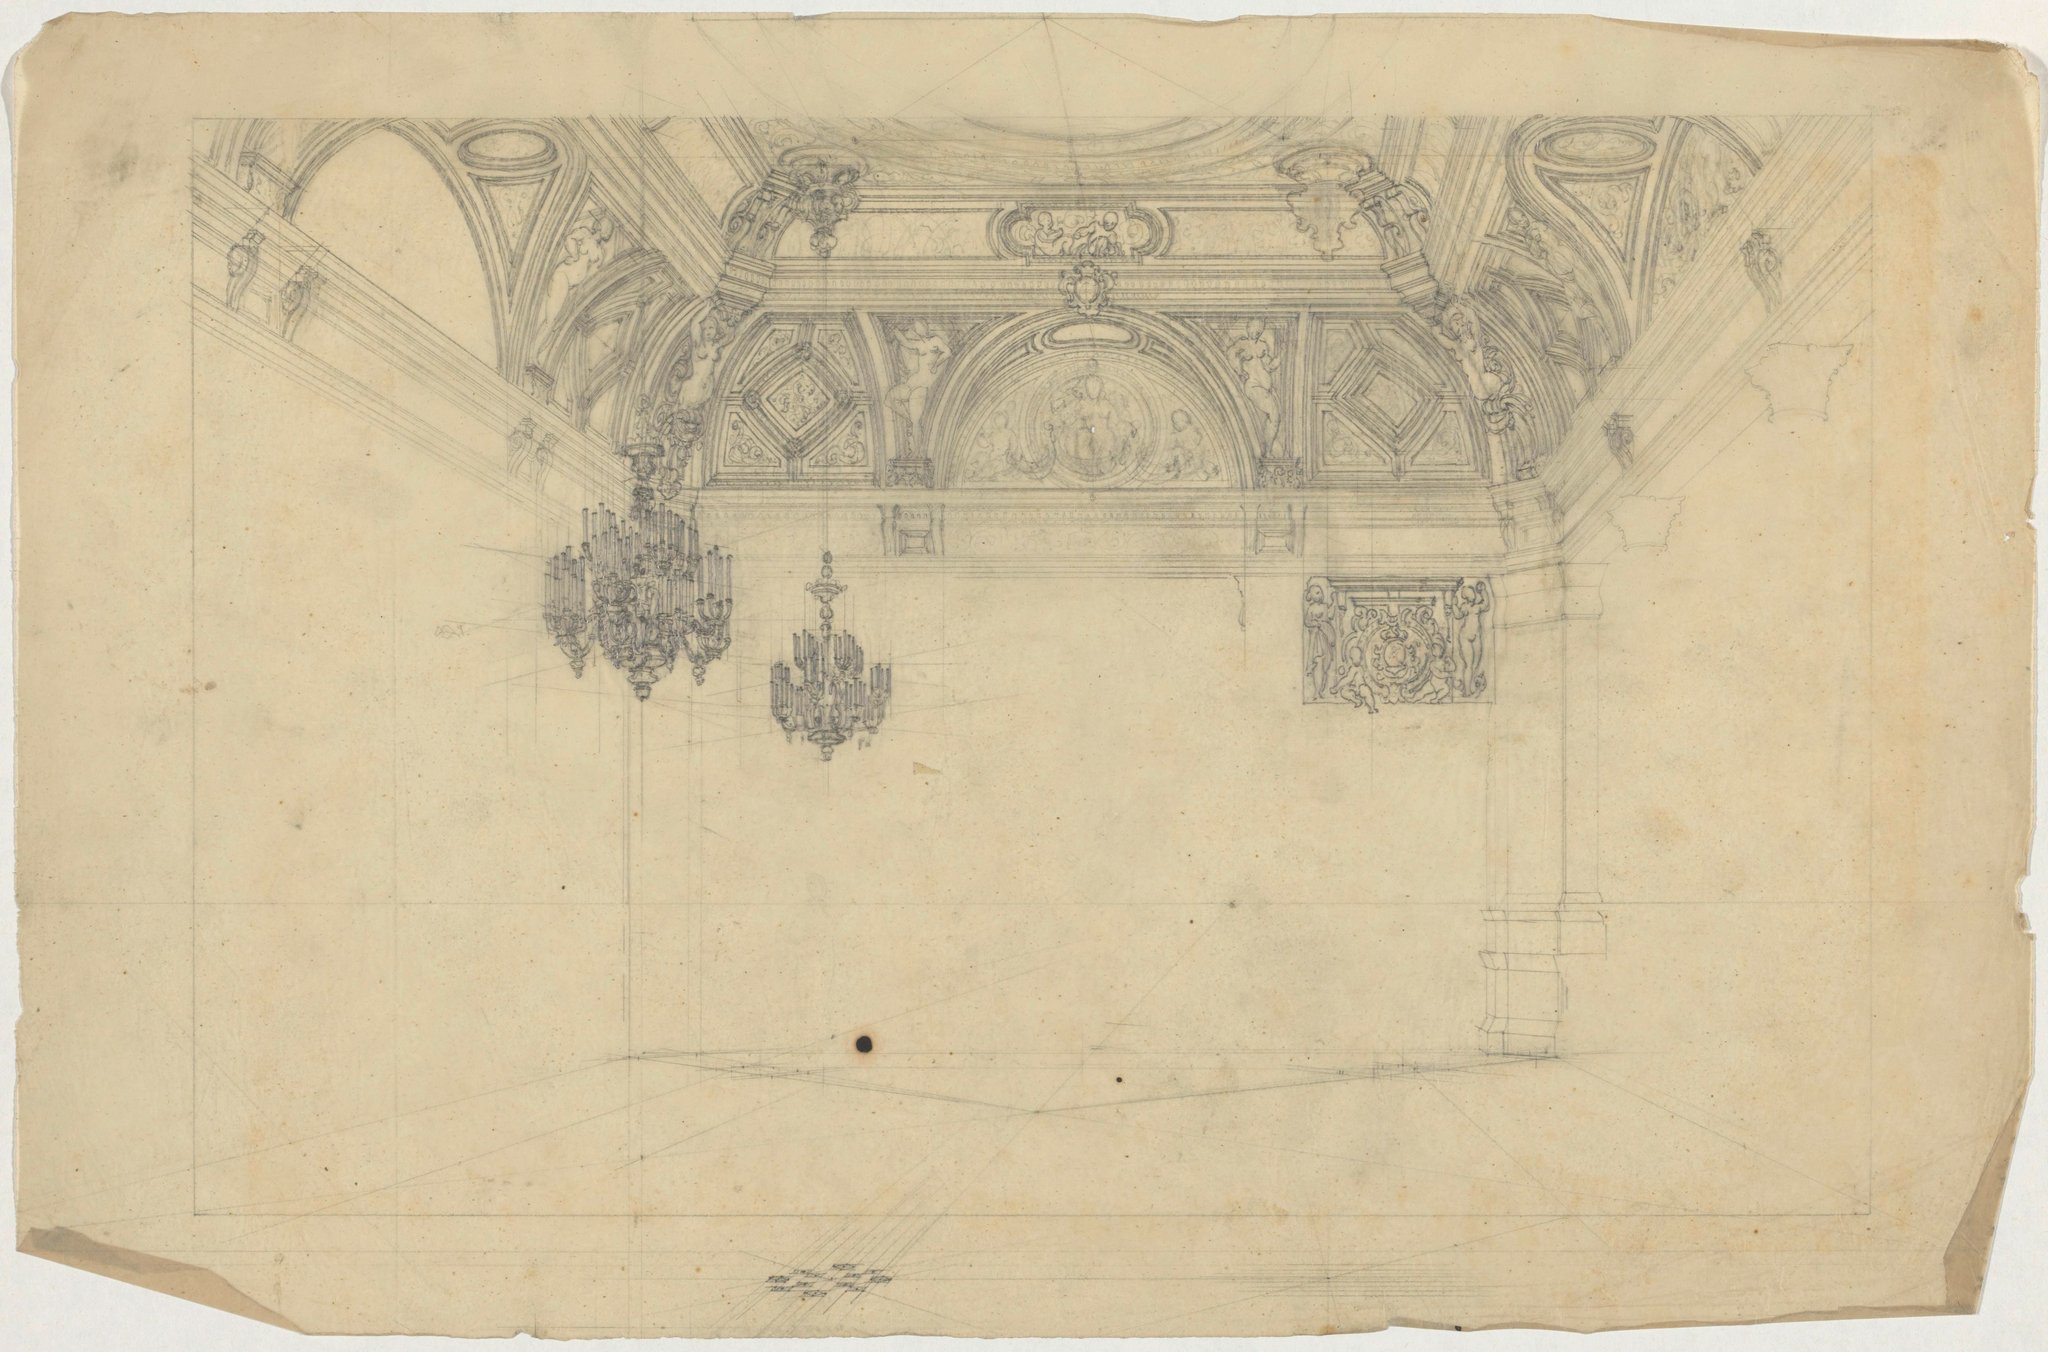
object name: design drawing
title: Interieur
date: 1830-1850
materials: graphite, paper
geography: paris